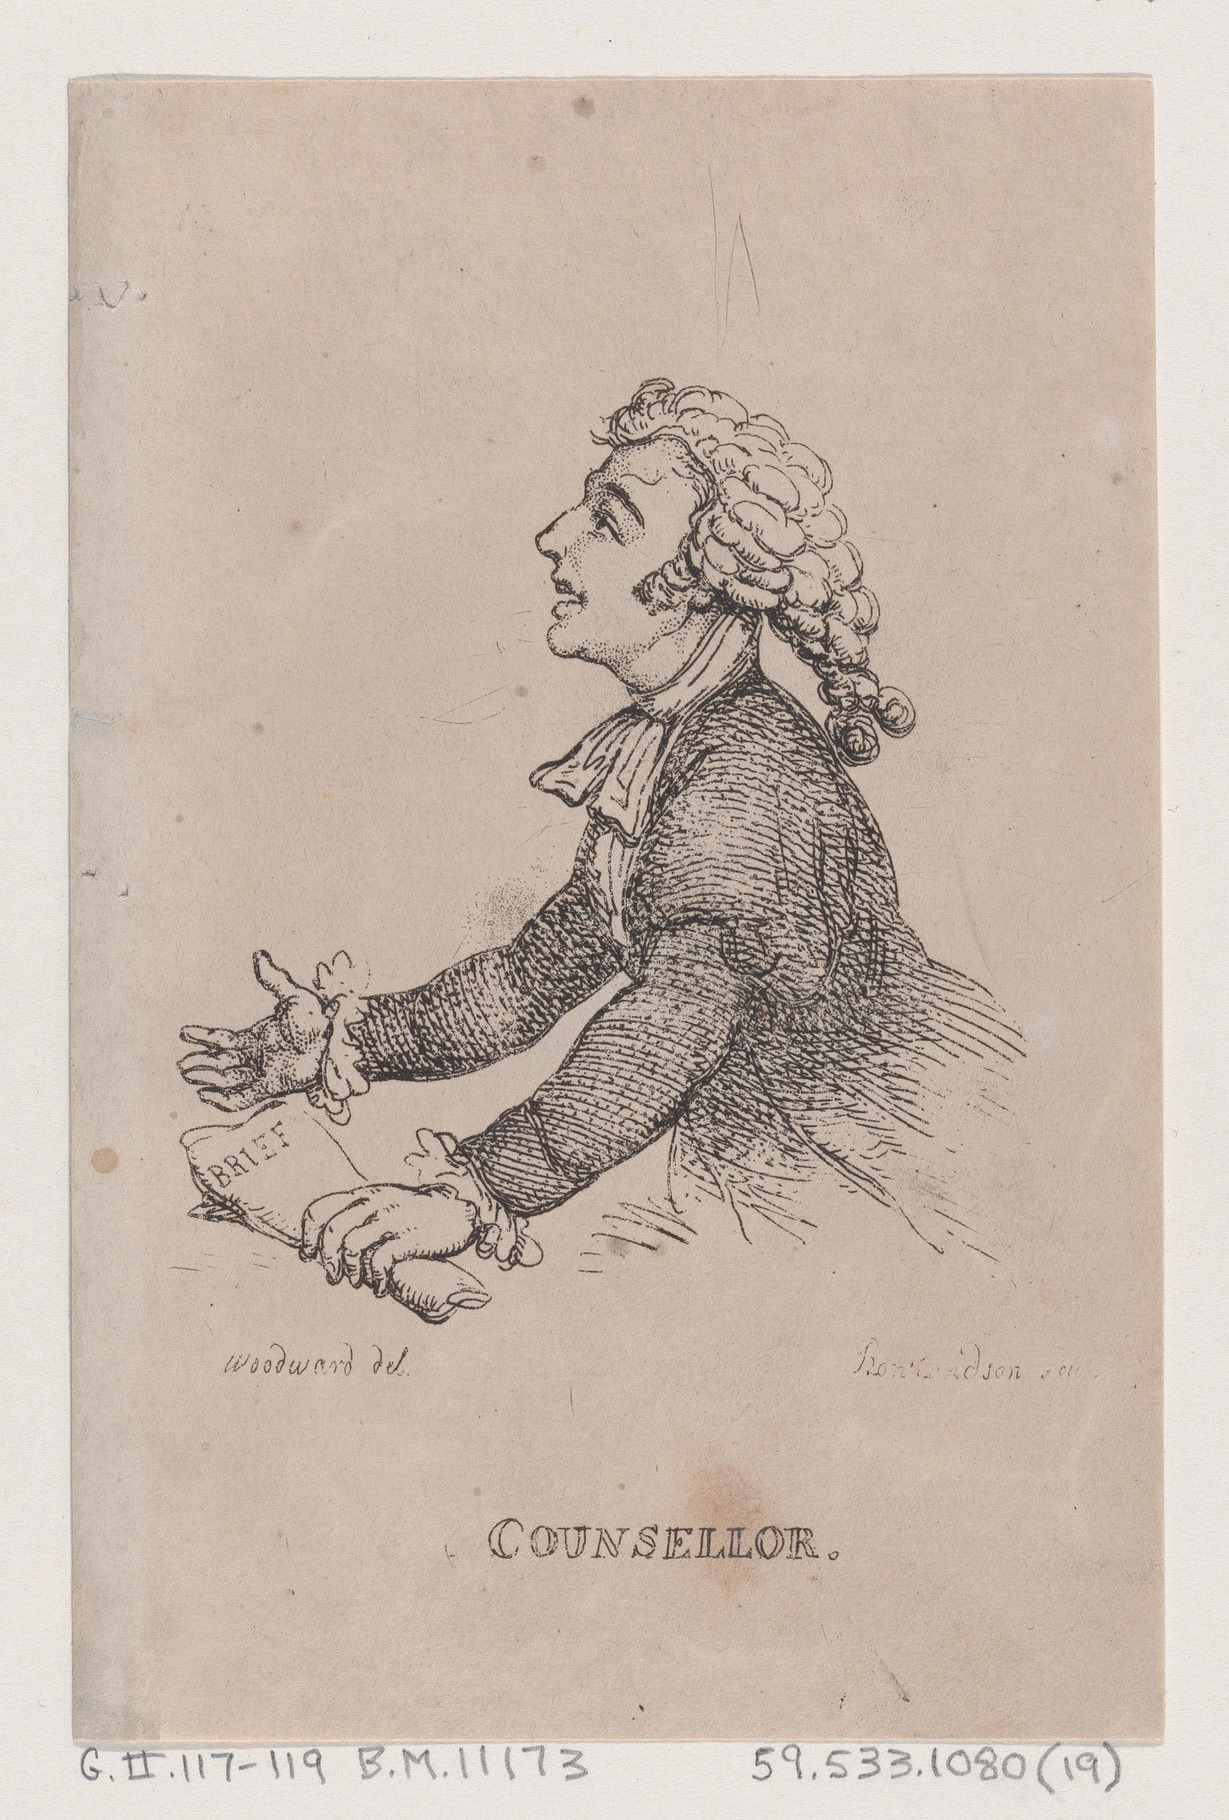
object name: print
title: Counsellor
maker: thomas rowlandson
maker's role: artist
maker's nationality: british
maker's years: 1757-1827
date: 1808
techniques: etching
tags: men,profiles